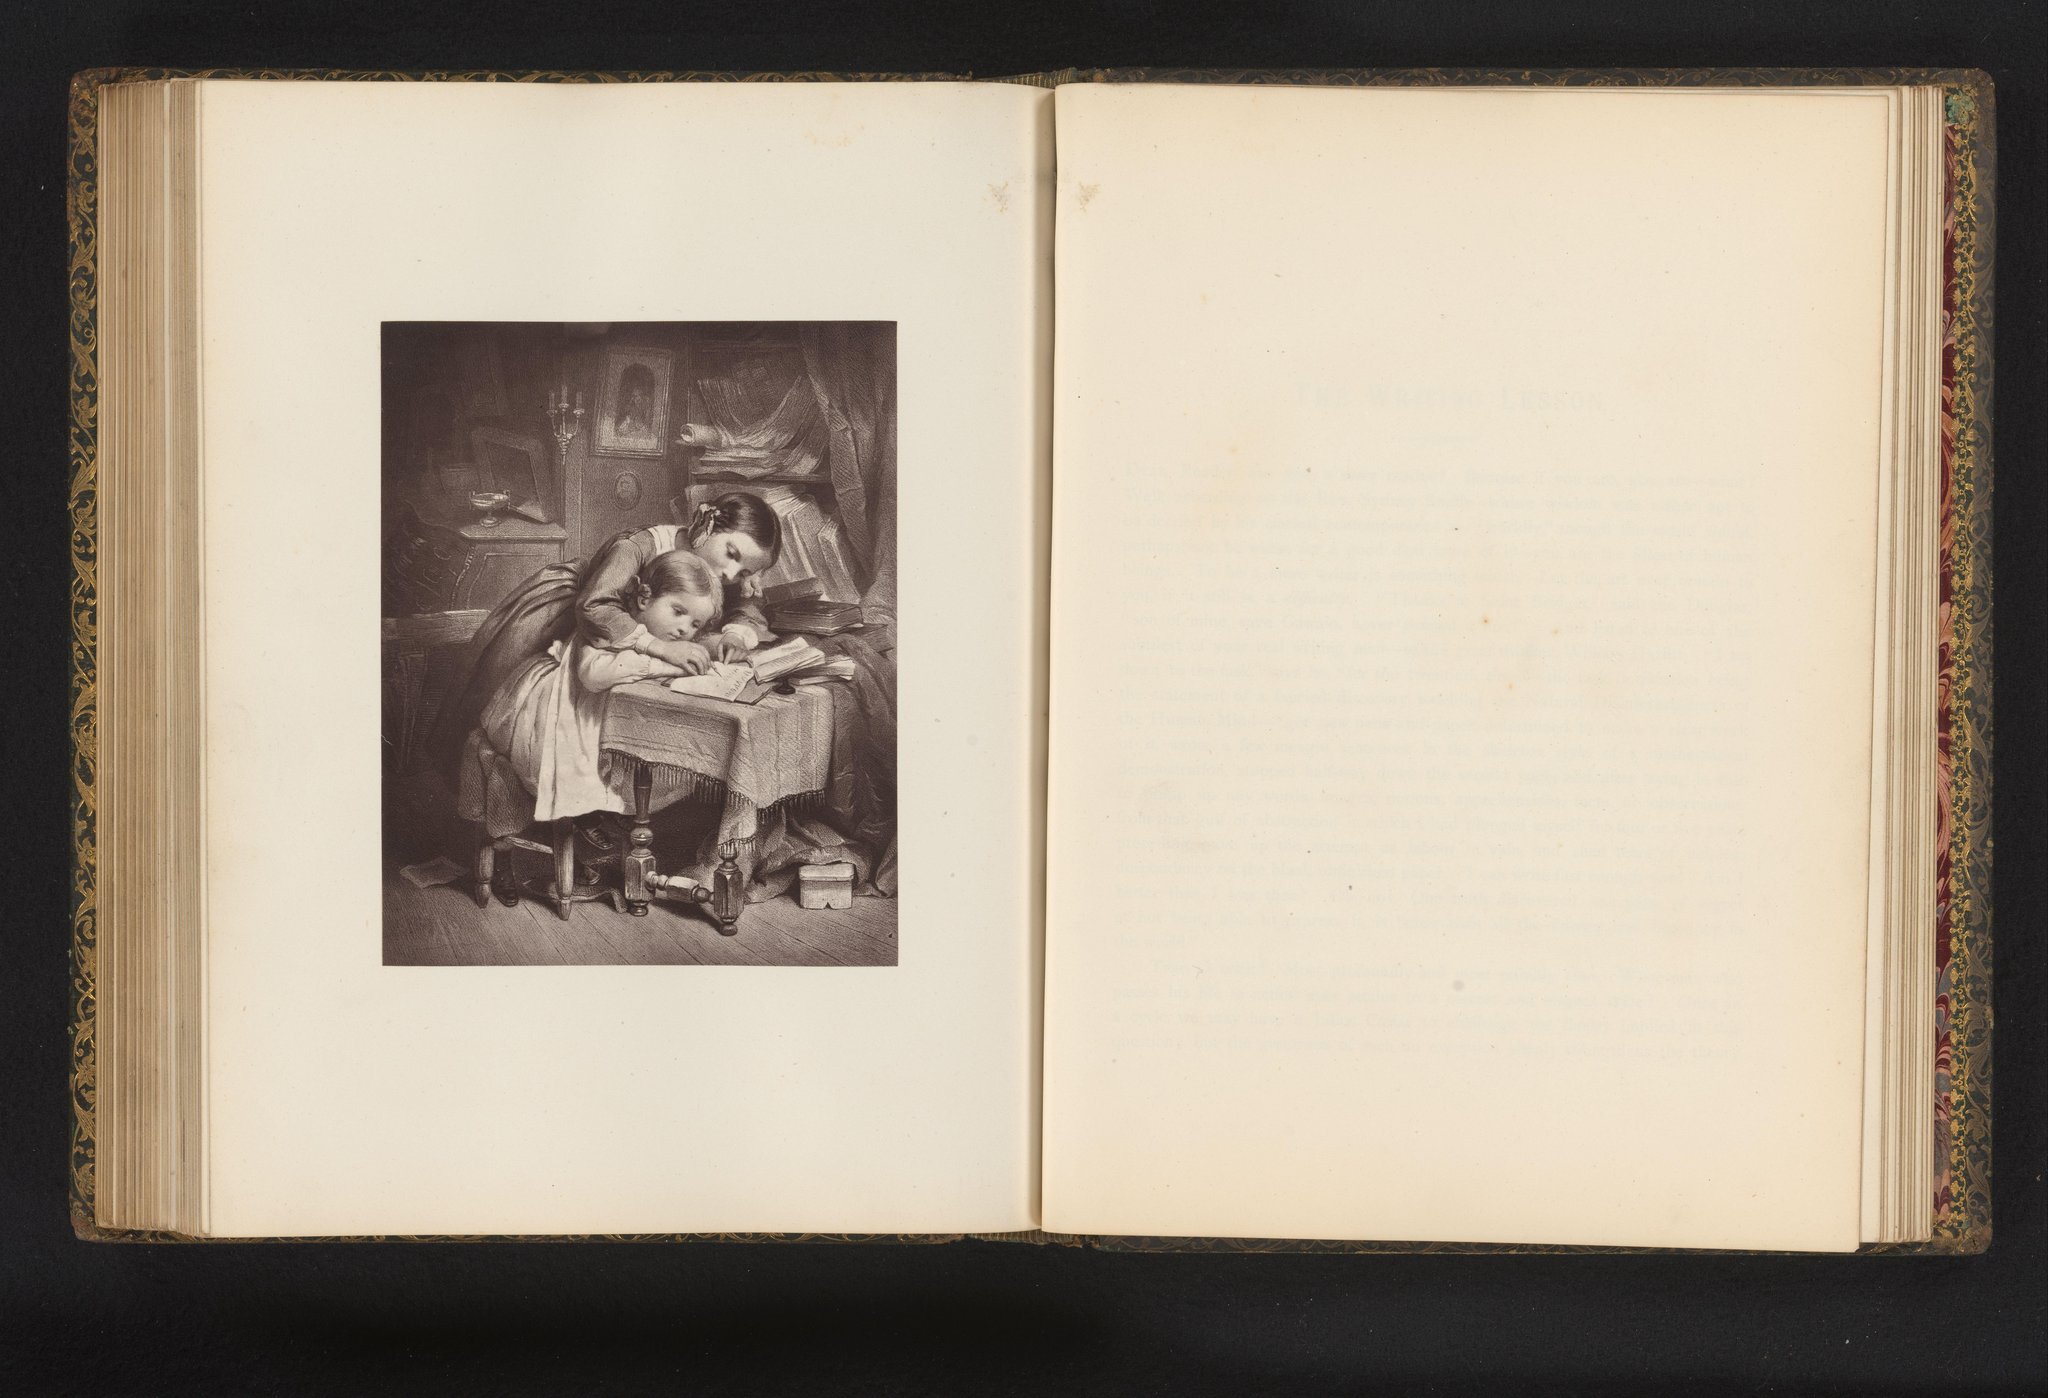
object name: reproduction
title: Fotoreproductie van een gravure naar het schilderij The writing lesson door François-Louis Lanfant de Metz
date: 1866-1871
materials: paper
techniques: woodburytype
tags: handwriting, writing as activity, taking care of children - aa - by other children, print, e.g.: engraving, etching, lithograph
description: Prent op tweede ongenummerde pagina na pagina 114.